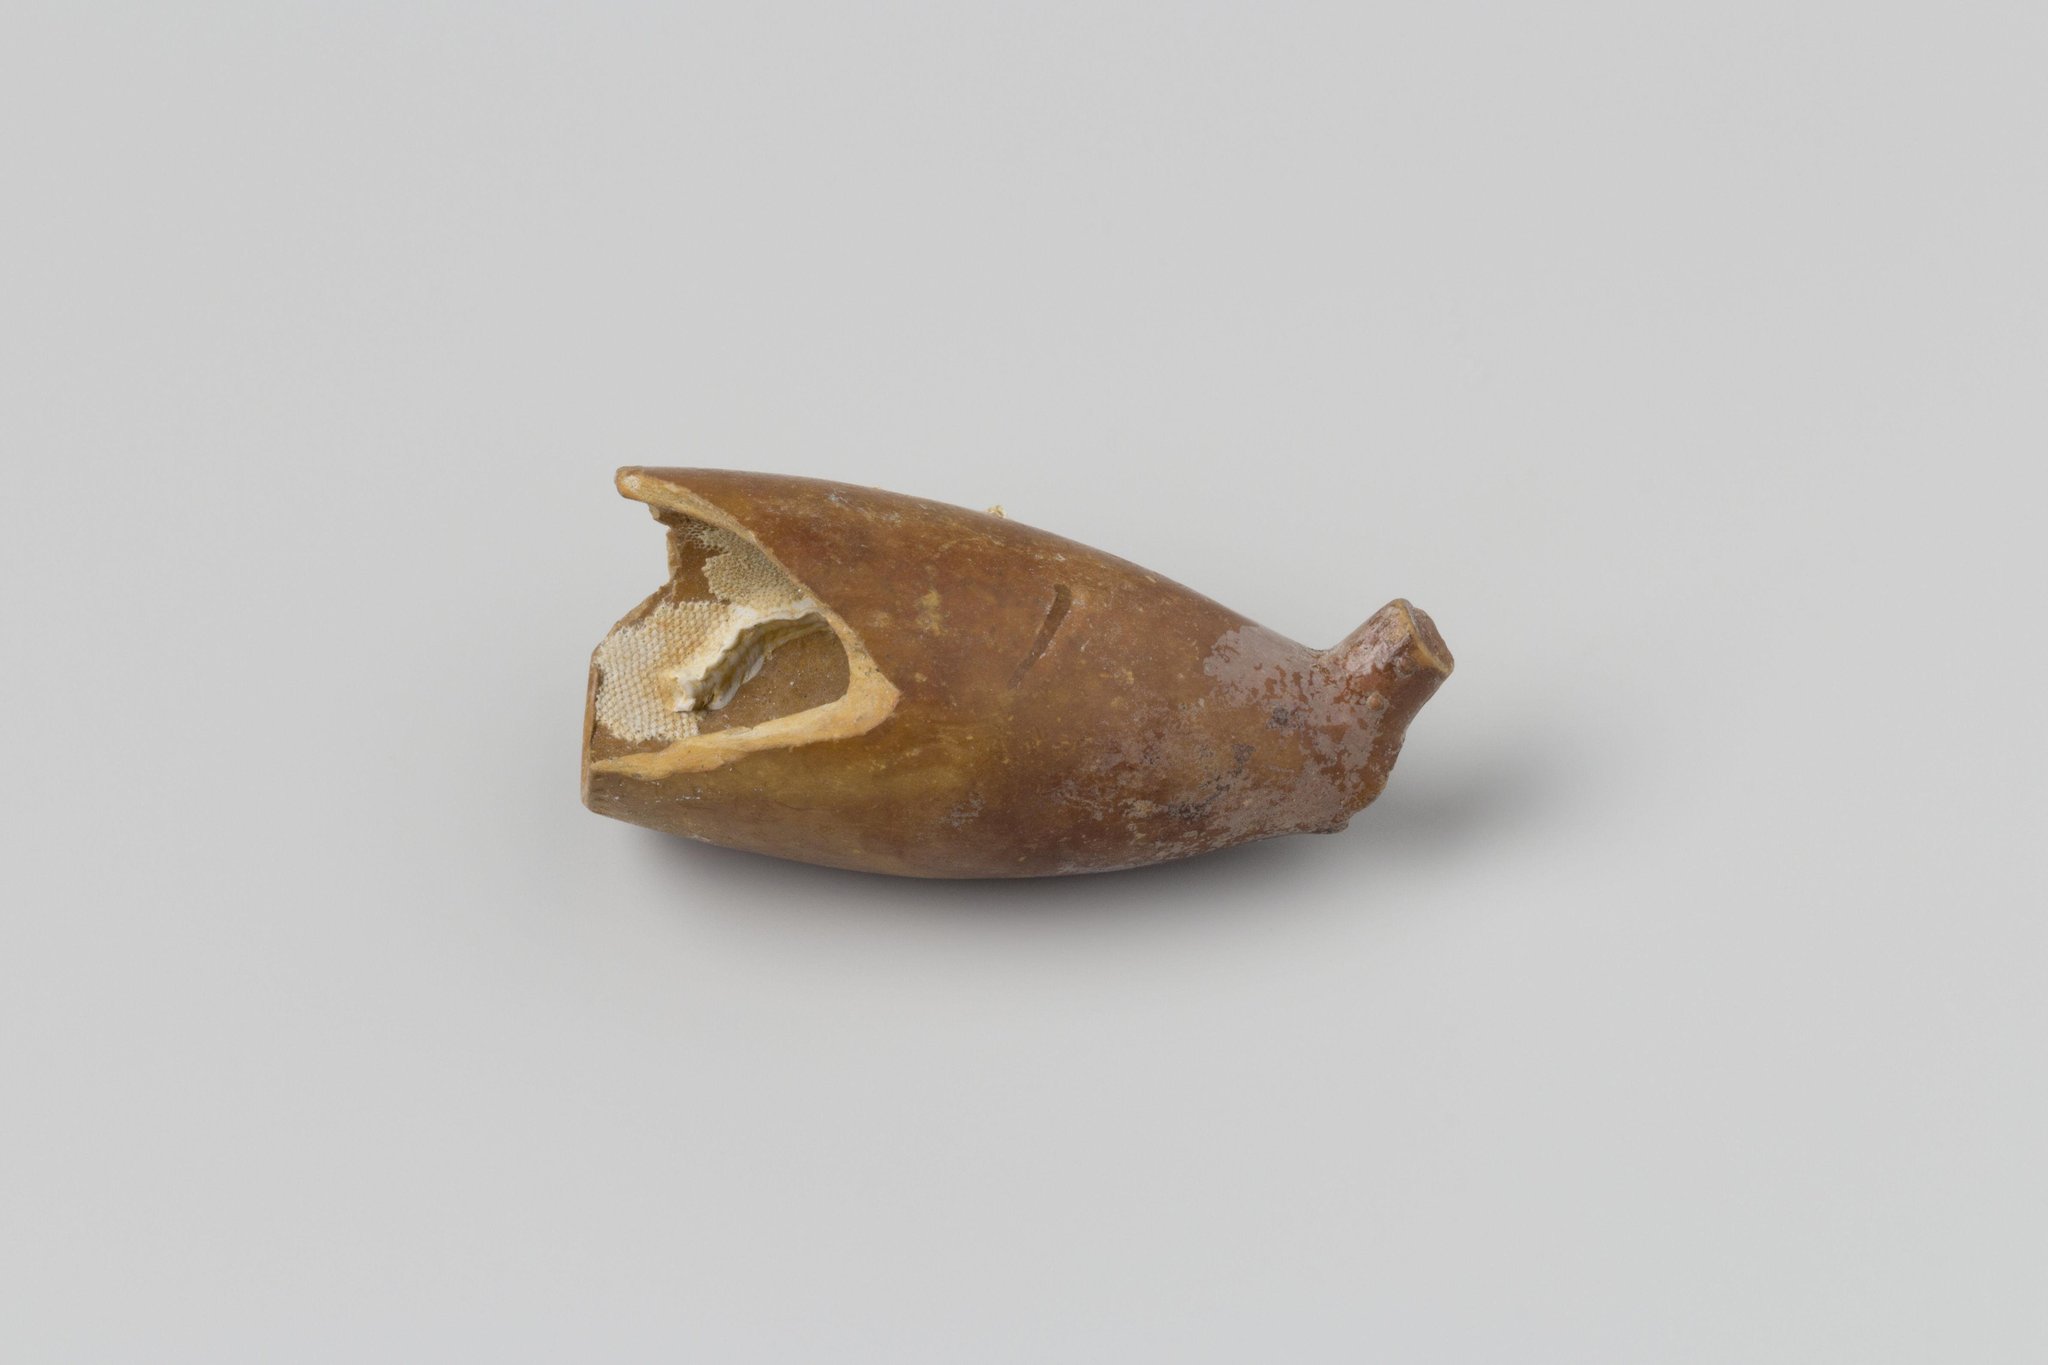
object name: pipe bowl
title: Fragment pijpenkop uit het wrak van de Oost-Indiëvaarder Hollandia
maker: Anonymous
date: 1700-1743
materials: clay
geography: netherlands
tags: verenigde oostindische compagnie, hollandia (schip), annet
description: Pipe, bowl, heelmark: fish, flounder; fragm, 2hsm1,5.